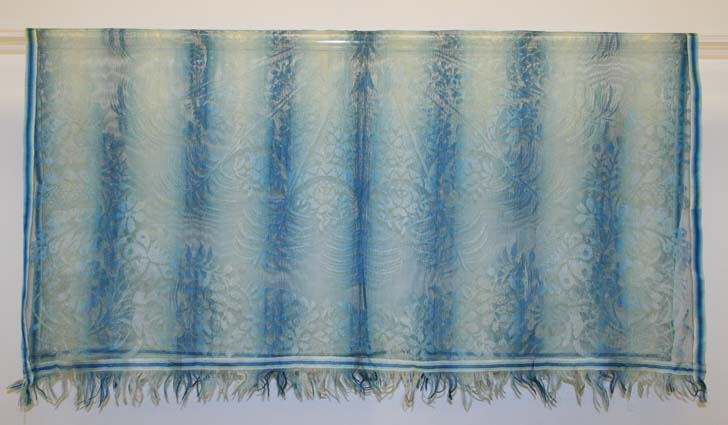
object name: shawl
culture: european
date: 1801-1825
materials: silk